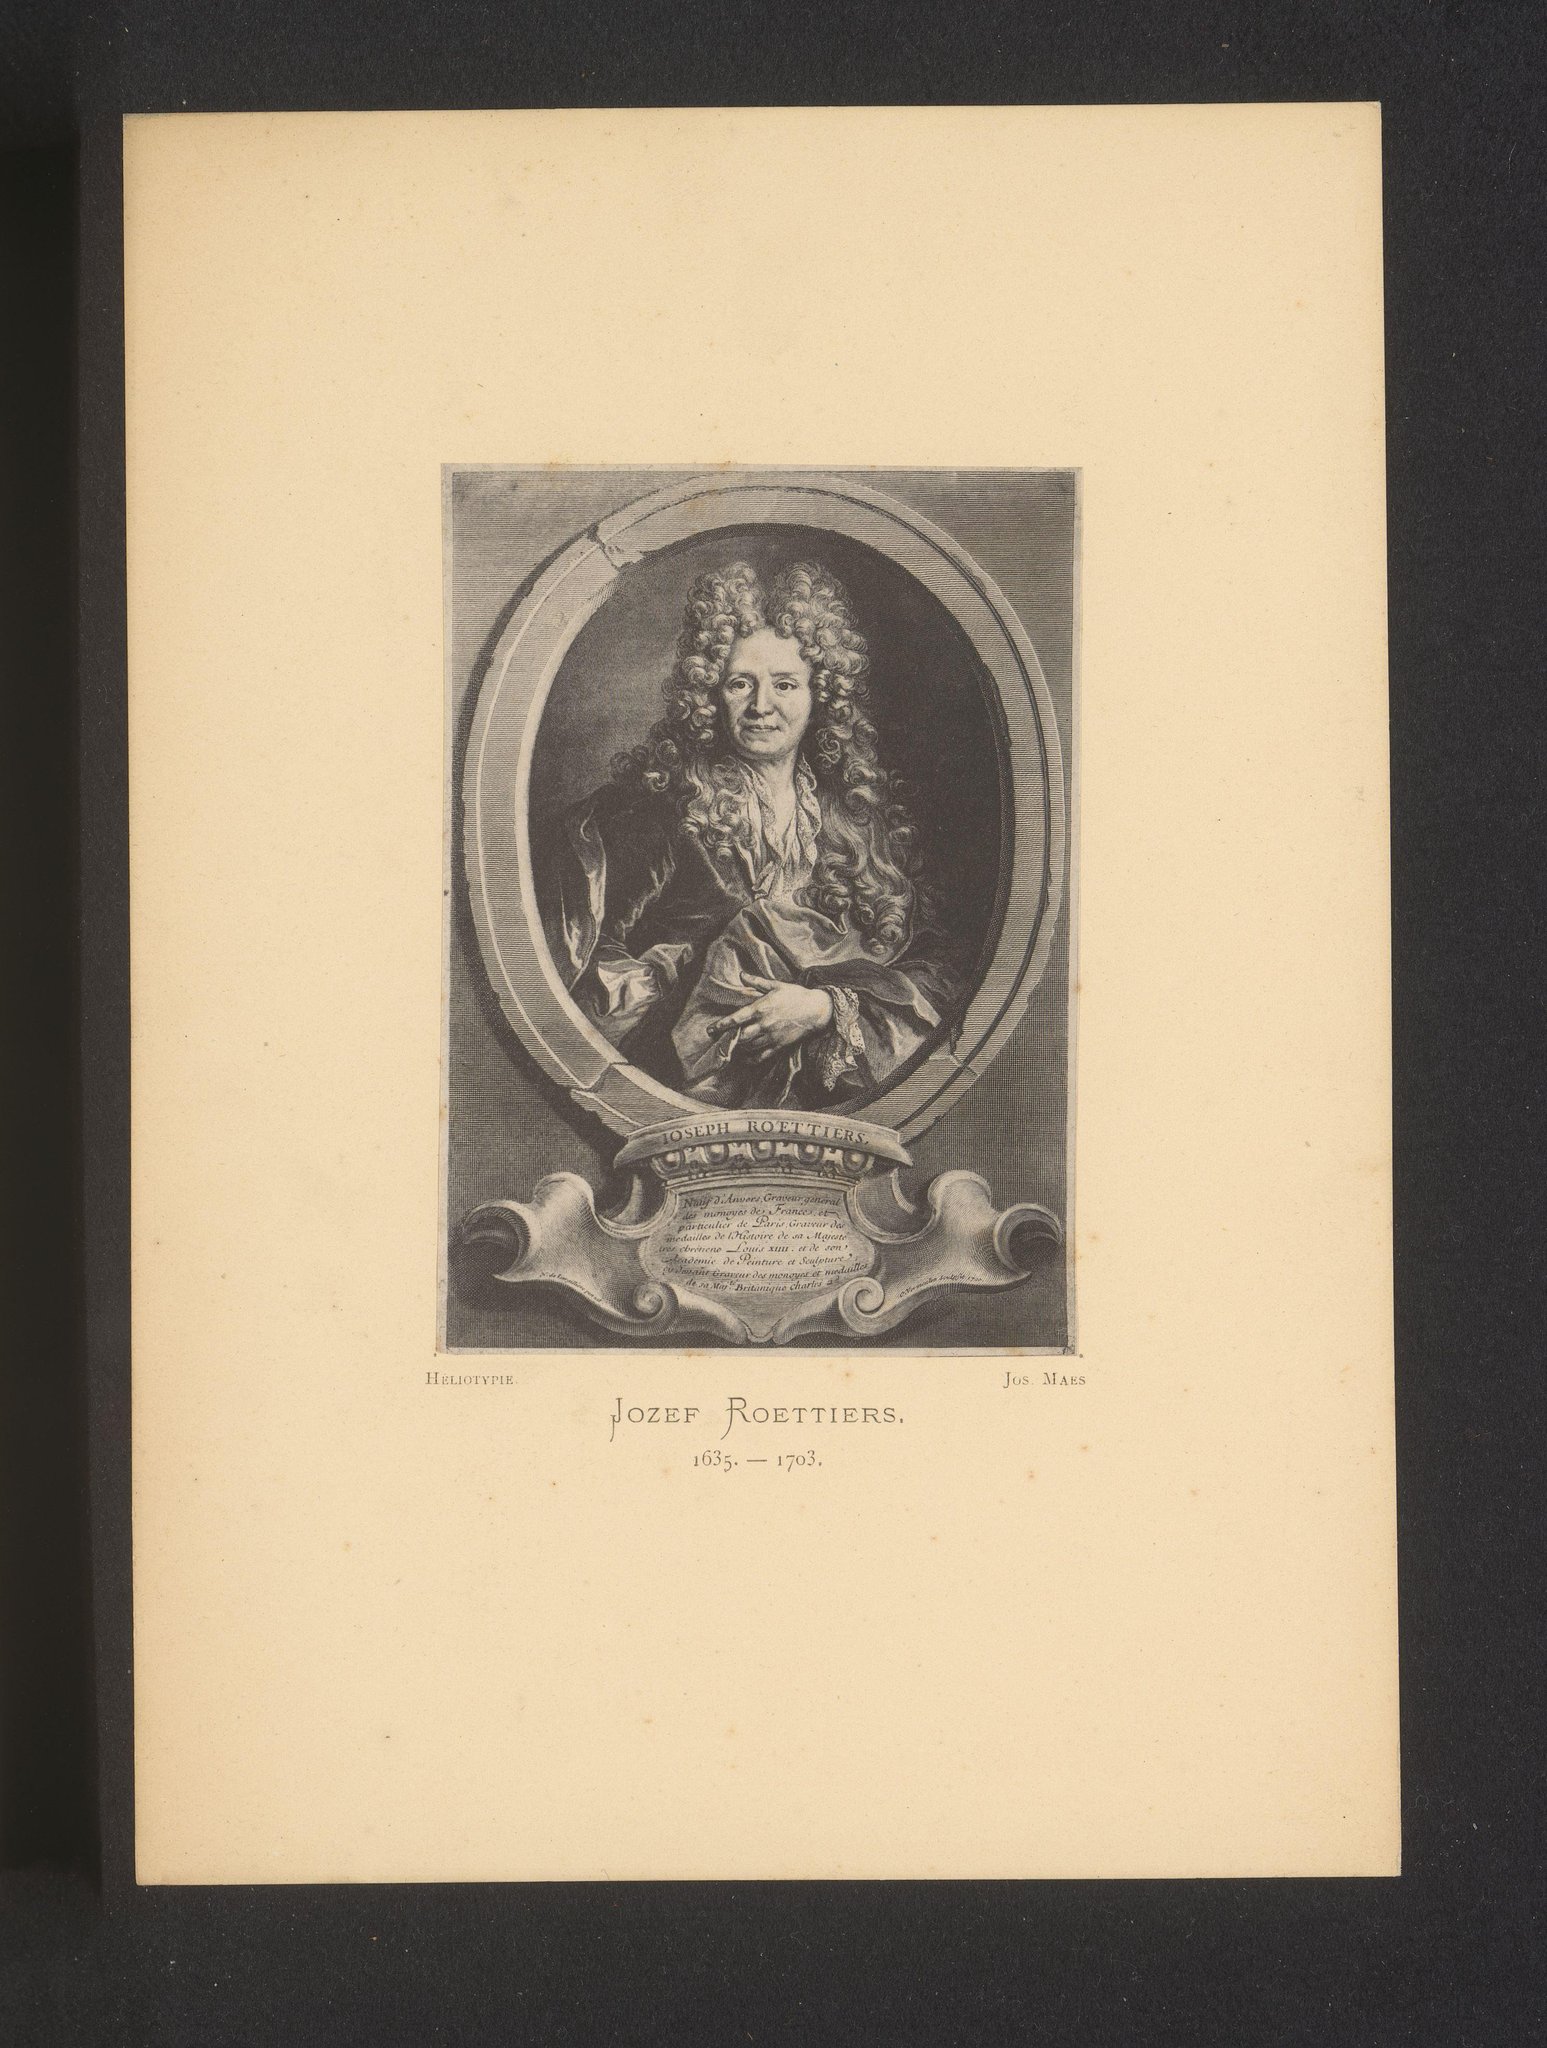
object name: photomechanical print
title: Jozef Roettiers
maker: joseph maes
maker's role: fotograaf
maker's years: 1838-1908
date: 1872-1877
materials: cardboard, paper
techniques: photograph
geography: antwerp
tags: antwerp, goldsmith, joseph roettiers, historical persons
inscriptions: inscription: ‘1635. - 1703.’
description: Deze prent maakt deel uit van een omslag met 150 prenten en een katern met een lijst van afbeeldingen.